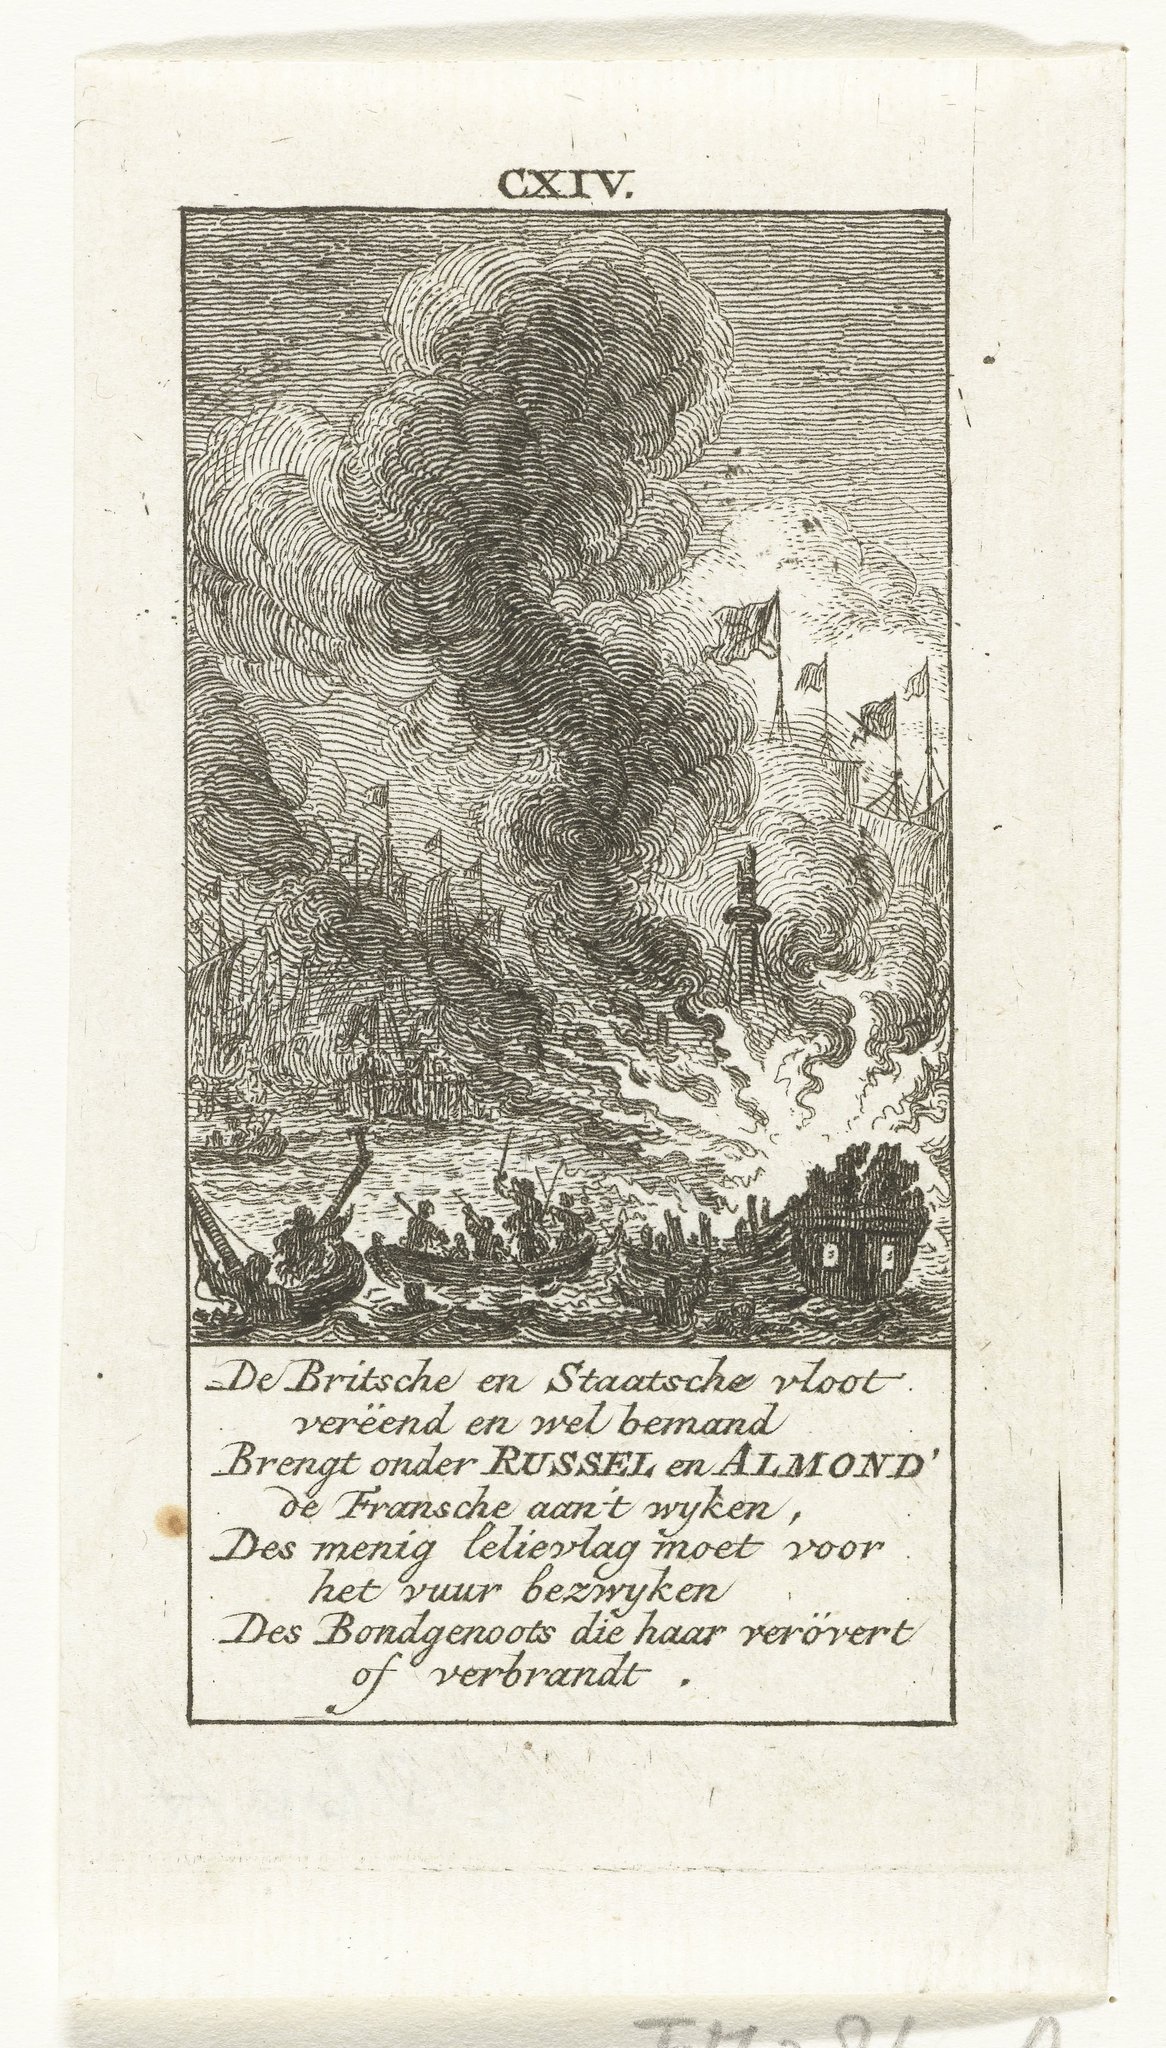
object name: history print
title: Zeeslag bij Kaap la Hogue, 1692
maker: simon fokke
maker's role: draughtsman, print maker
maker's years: 1712-1784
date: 1779-1781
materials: paper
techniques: etching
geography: northern netherlands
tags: paris, battle (+ naval force)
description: Gebruikt als illustratie in: Jacobus Kok, Amsteldamsche jaarboeken, behelzende de merkwaardigste geschiedenissen, welken, zo binnen de stad als daaromtrent, zijn voorgevallen, sedert haare eerste beginselen, tot op den tegenwoordigen tijd ... / Bijeengebragt door Jacobus Kok, 3 dln., J.B. Elwe, Amsterdam 1781. Niet in Frederik Muller; door het RPK toegevoegd nummer.